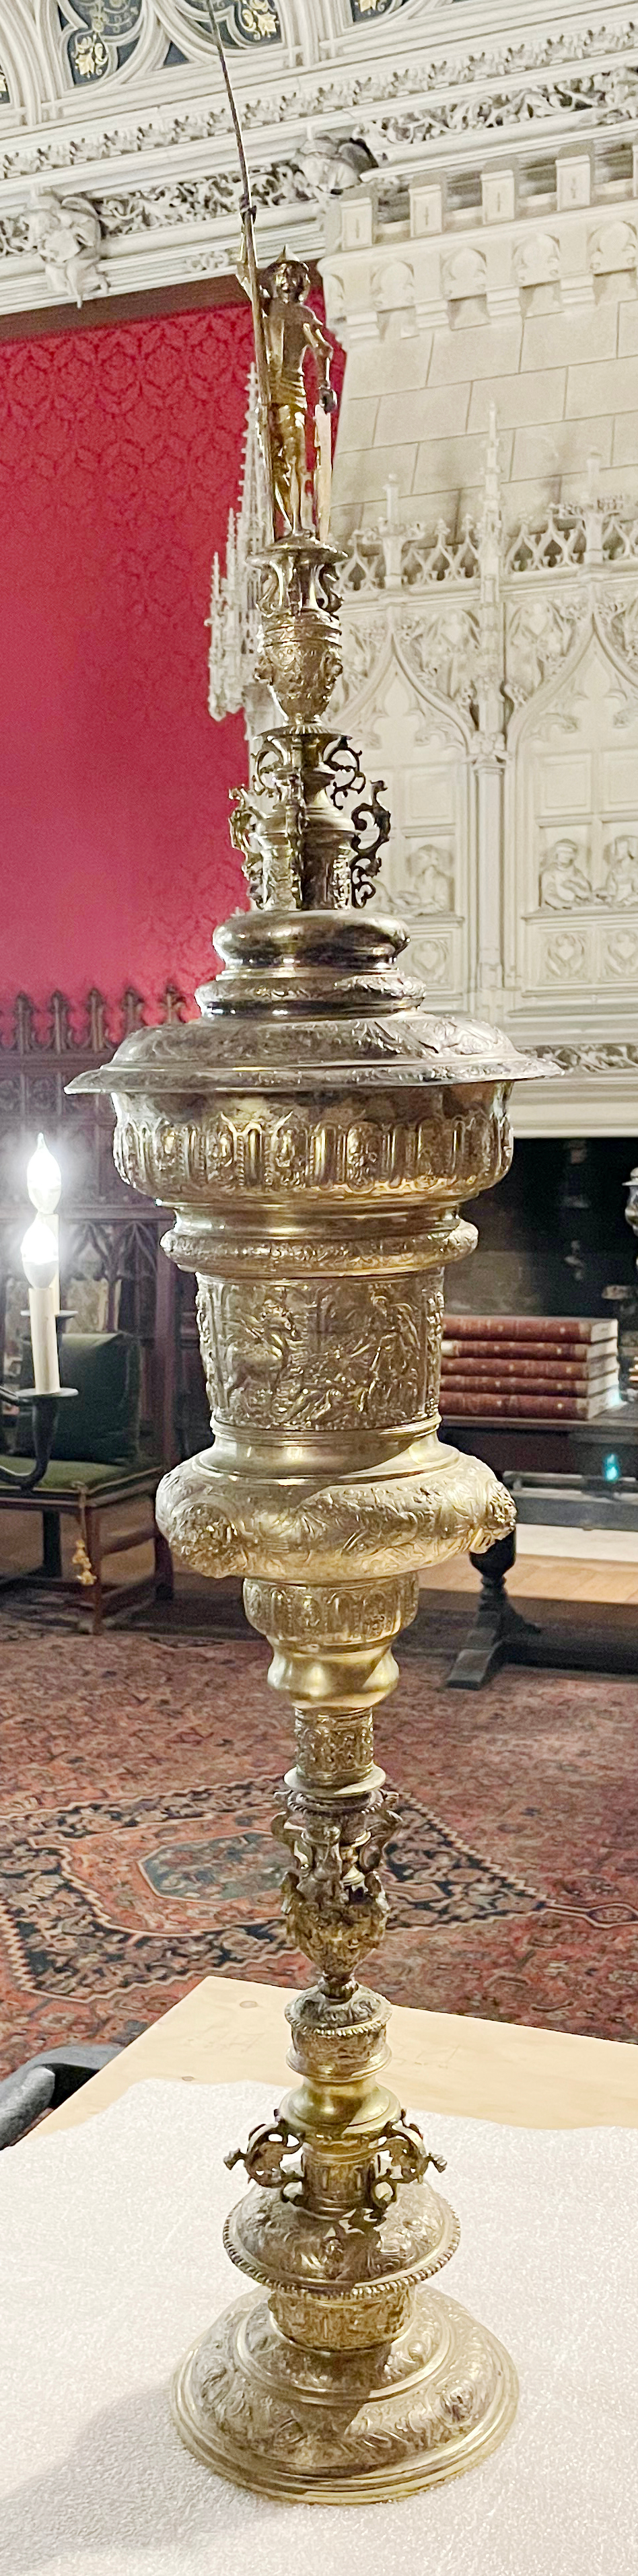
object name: cup with cover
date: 1801-1900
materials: metal, silver